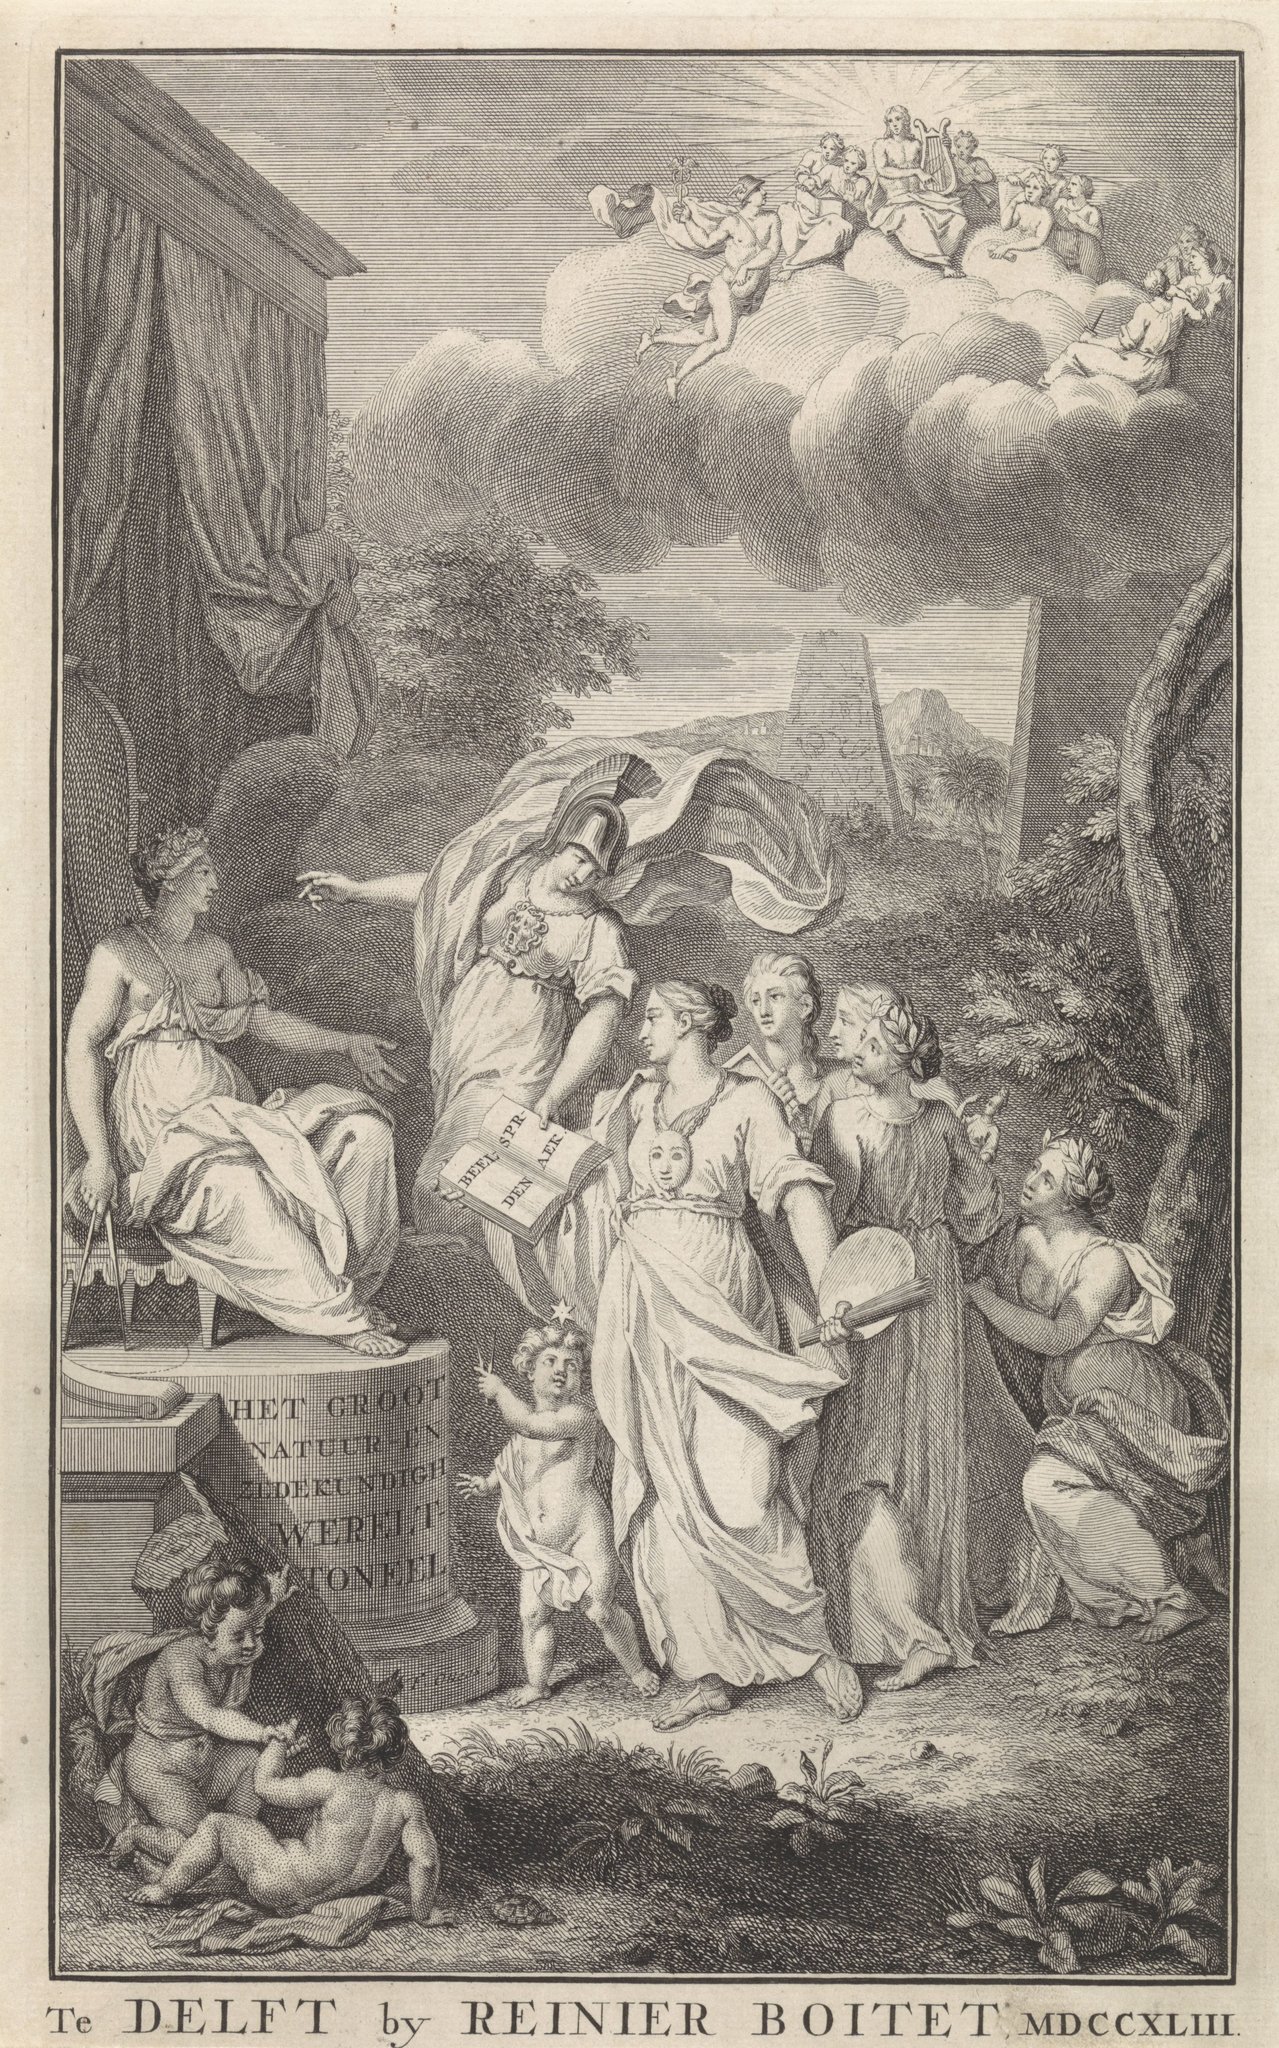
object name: print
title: Minerva en de Kunsten voor een tronende figuur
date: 1726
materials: paper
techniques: engraving, etching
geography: delft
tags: minerva as patroness, symbolic representations, allegories and emblems ~ art; 'arte' (ripa)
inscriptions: collector's mark: Lugt 2228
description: Minerva en personificaties van de kunsten staan voor een vrouw met passer in haar hand die troont op een sokkel met daarop de titel van het boek. In de hemel de goden op een wolk met prominent in het midden Apollo die op de lier speelt.